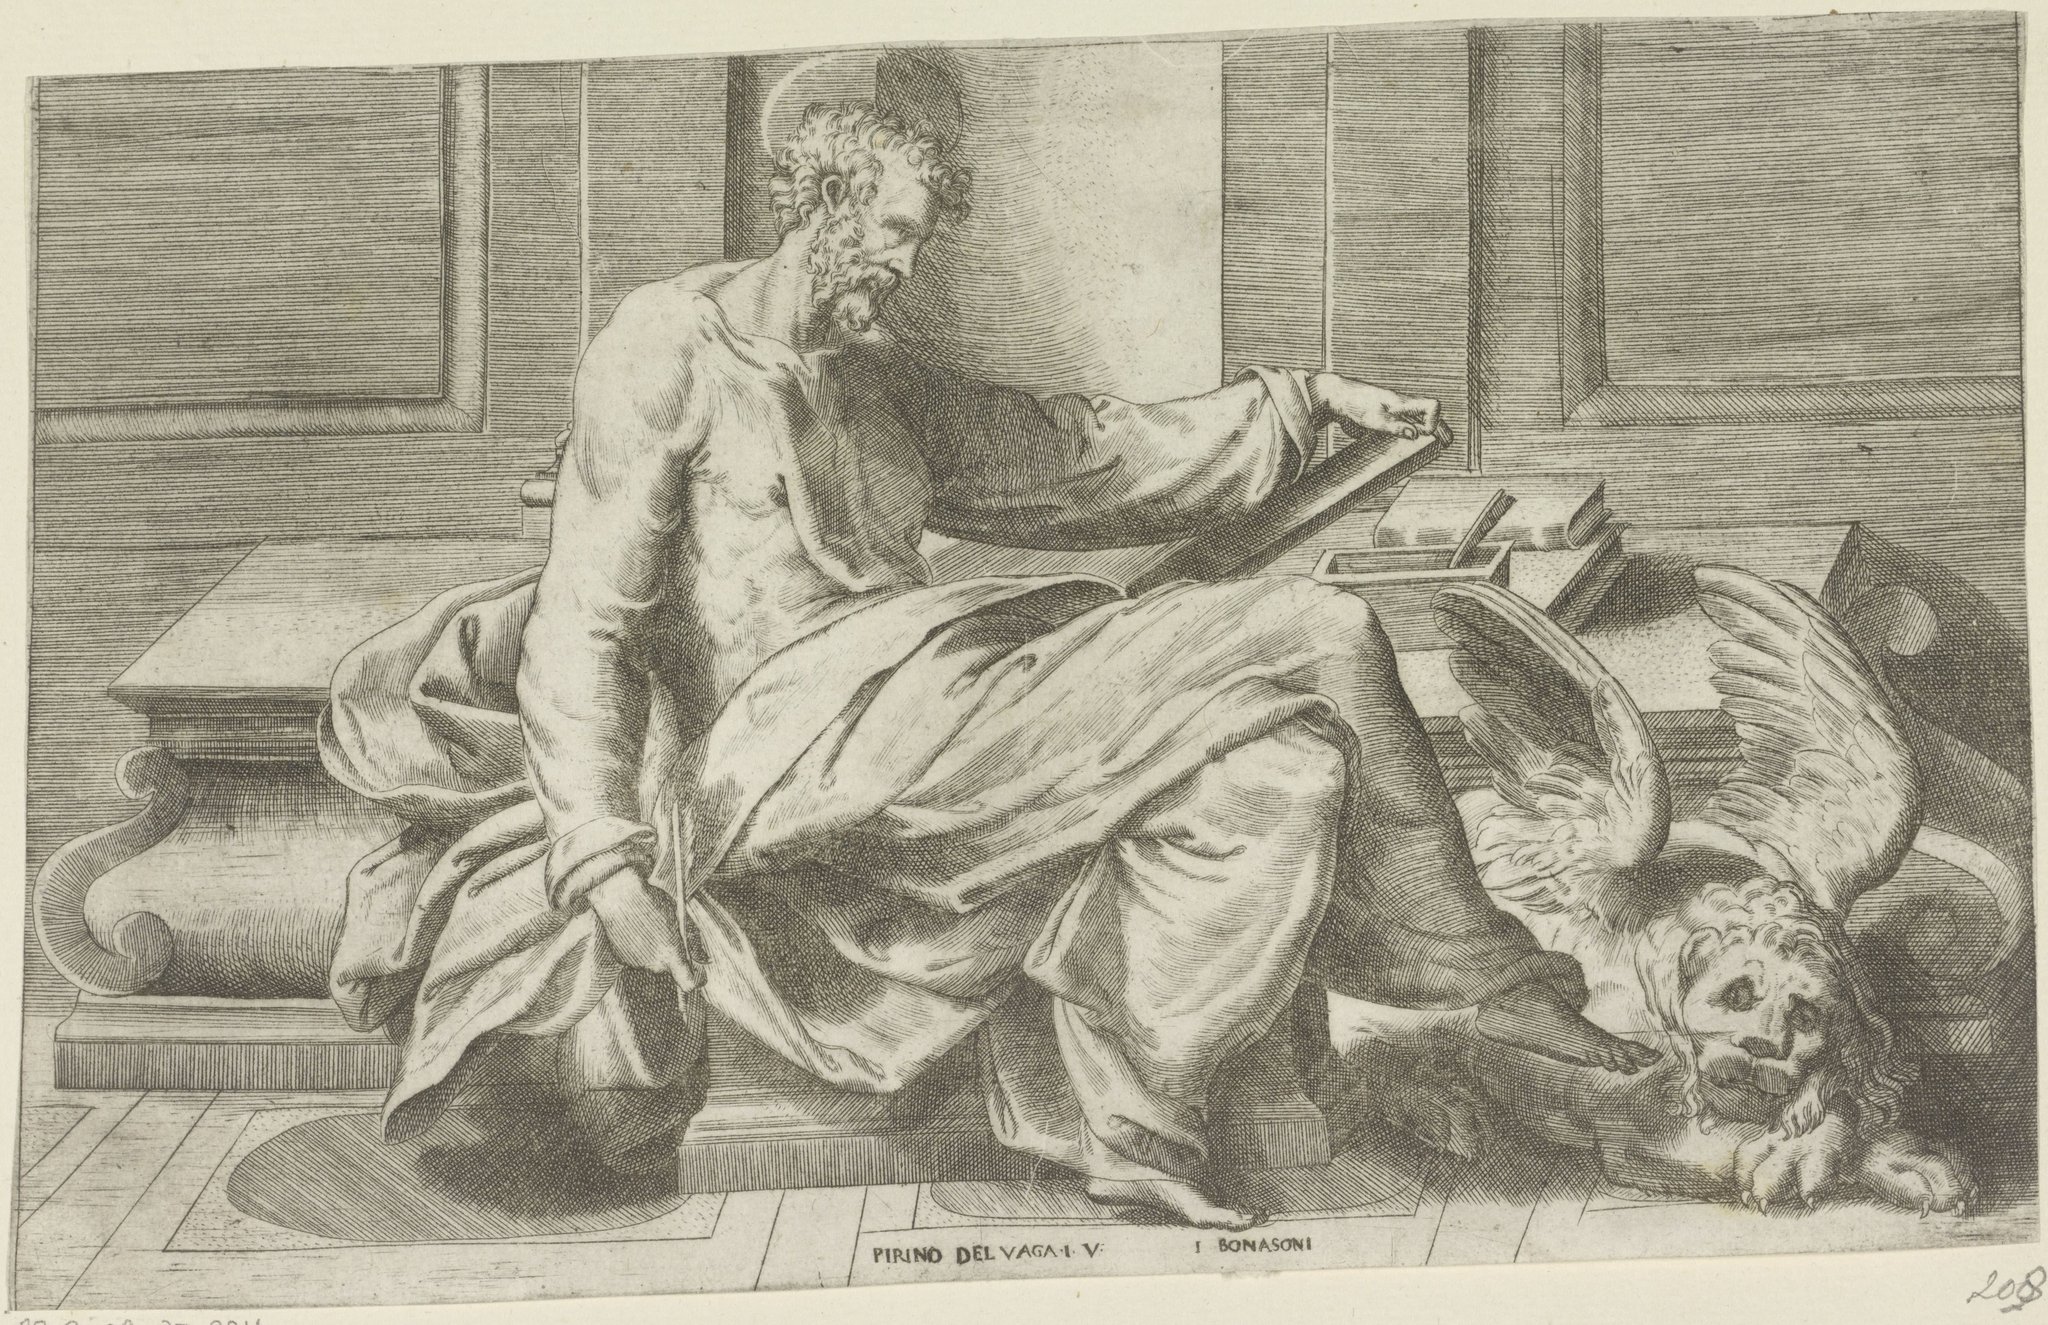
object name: print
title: Heilige Marcus schrijft zijn Evangelie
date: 1501-1580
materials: paper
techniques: engraving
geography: italy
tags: st. mark the evangelist writing the gospel, usually a (winged) lion present, mark (marcus) the evangelist, and bishop of alexandria; possible attributes: book, (winged) lion, pen and inkhorn, scroll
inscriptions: collector's mark: Lugt 240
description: De heilige Marcus schrijft zijn Evangelie. Hij zit bij een zuil, met in zijn rechterhand een pen en in zijn linkerhand een tablet. Bij zijn voeten ligt een gevleugelde leeuw.